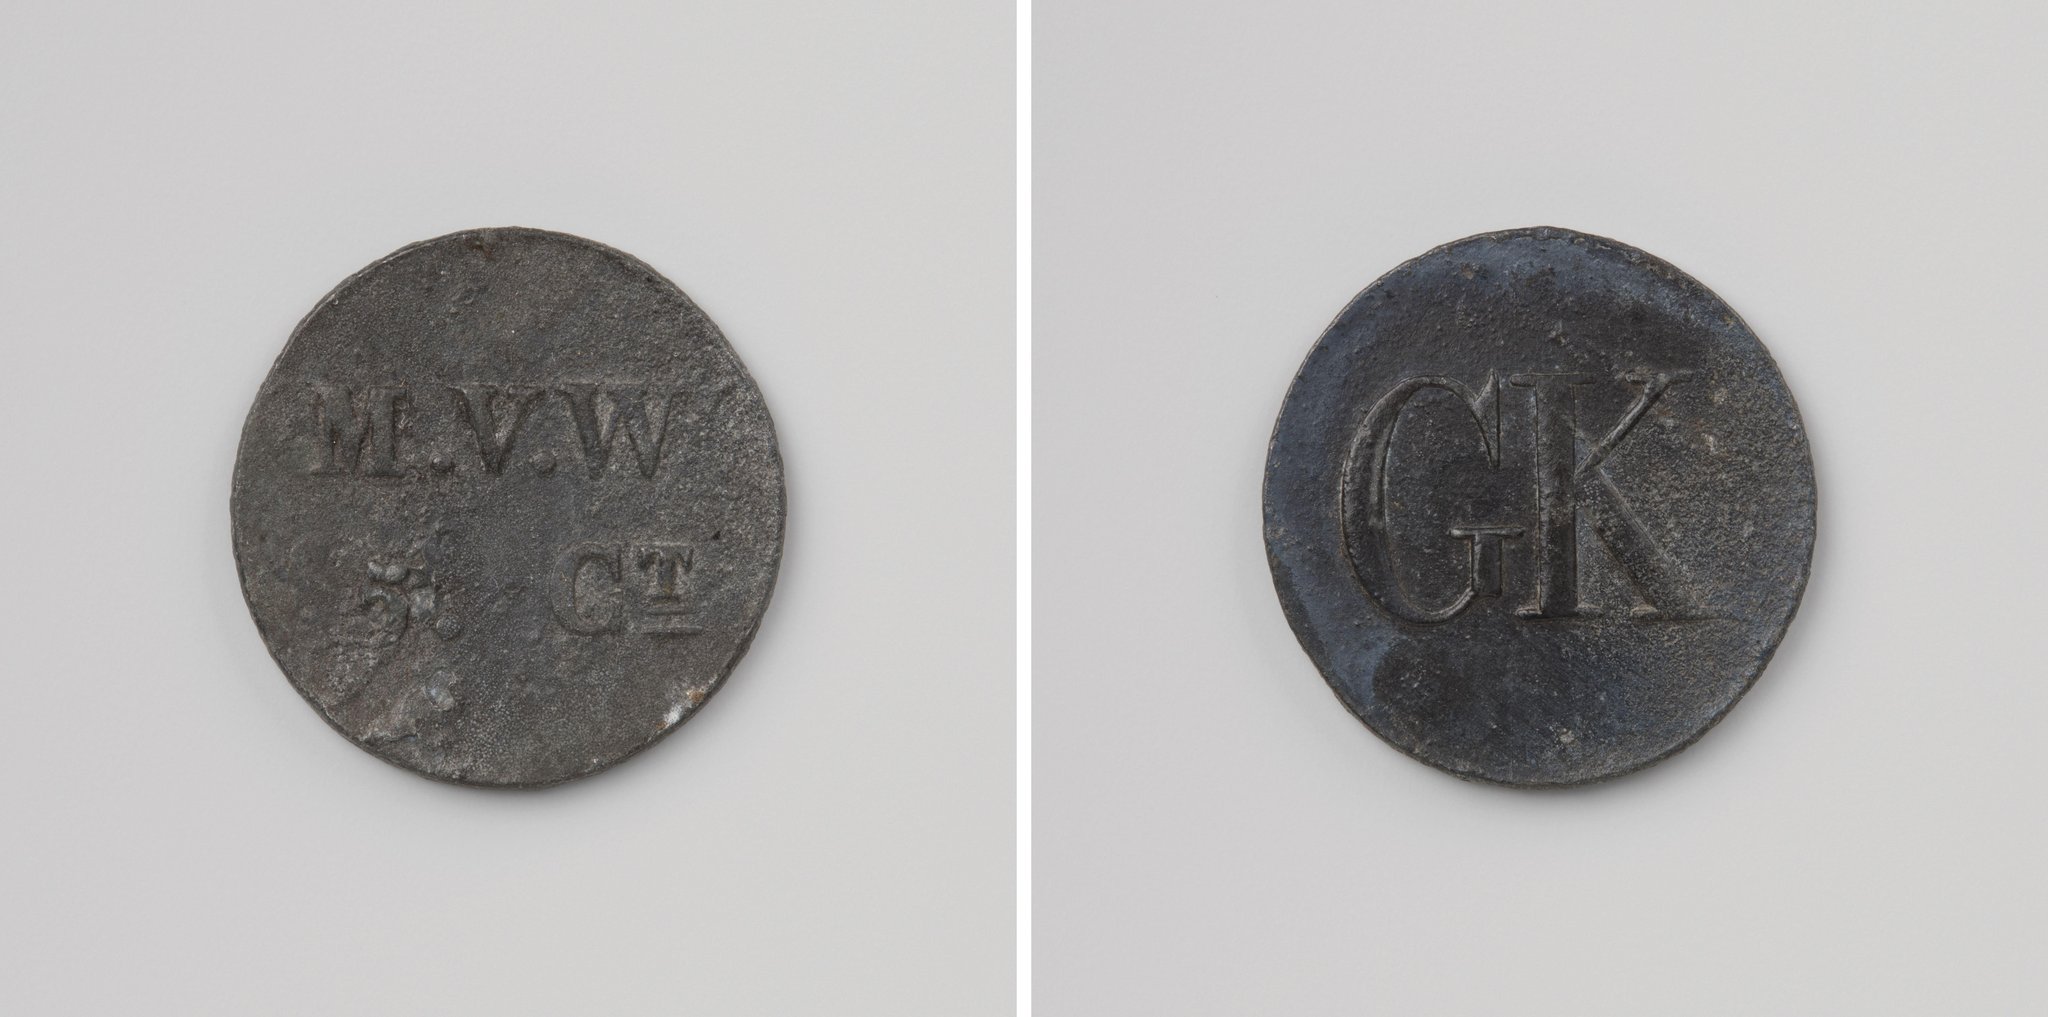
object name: vijf cent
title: Huismunt geslagen op last van de Maatschappij van Weldadigheid ter waarde van vijf cent, ten behoeve van de Gewone Koloniën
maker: Anonymous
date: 1818-1859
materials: zinc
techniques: striking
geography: netherlands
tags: maatschappij van weldadigheid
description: Zinken munt. Voorzijde: opschrift boven waardeaanduiding. Keerzijde: opschrift G en K.